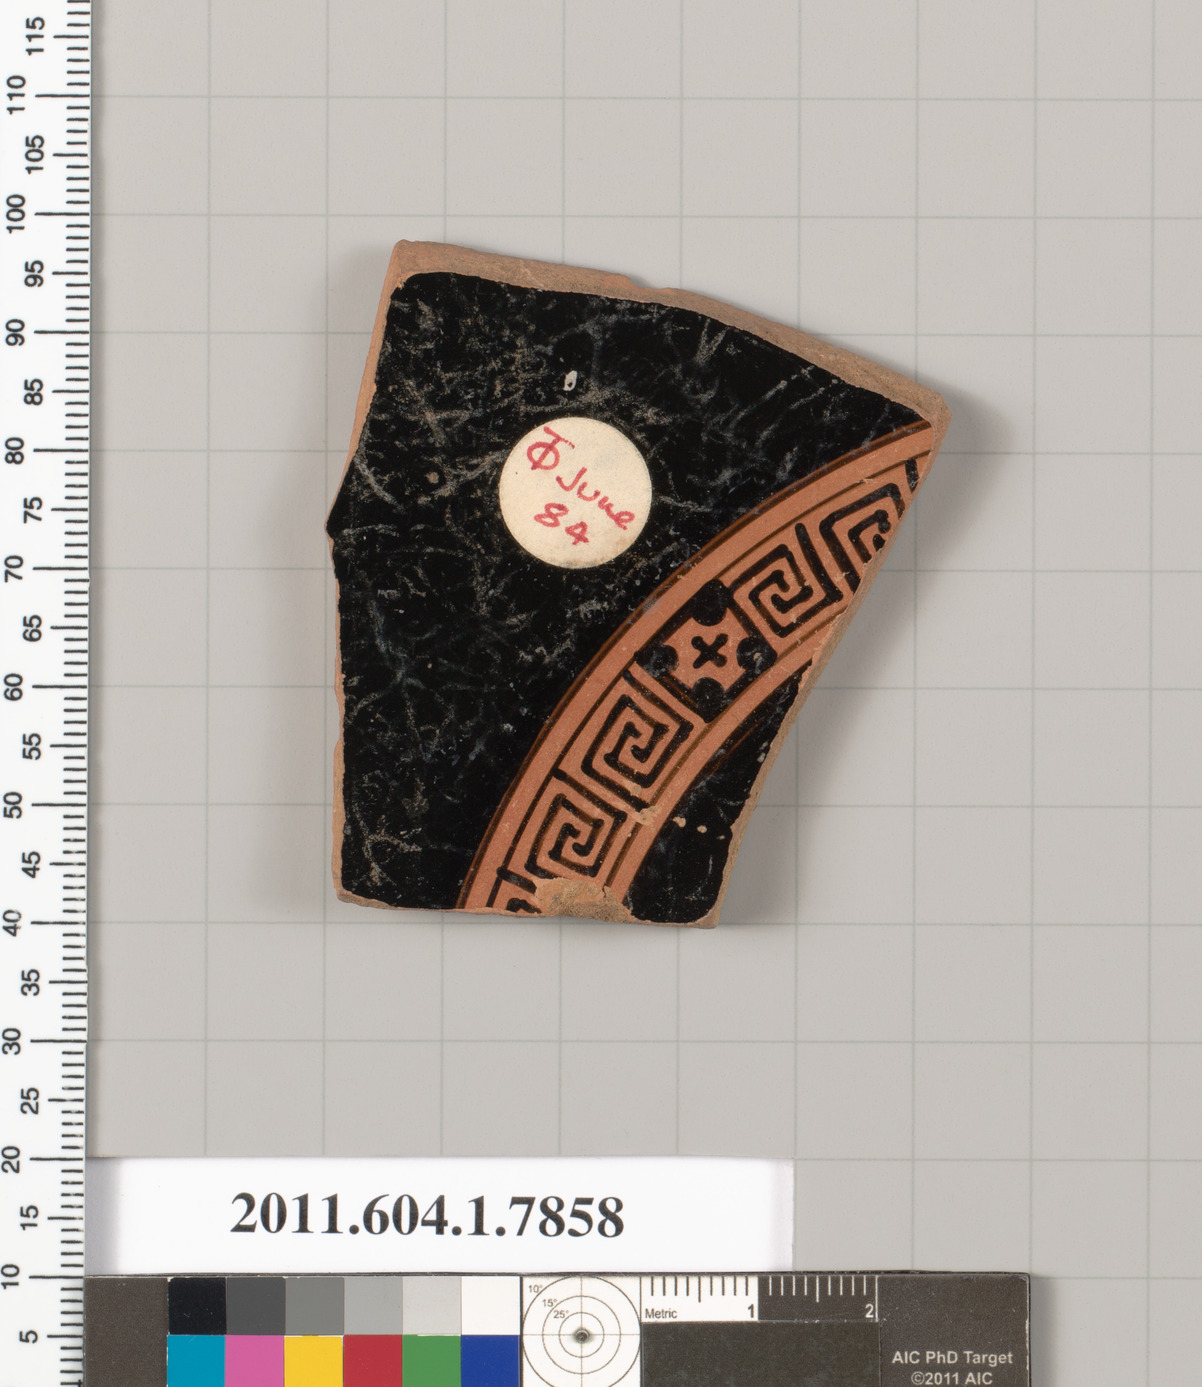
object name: kylix fragment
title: Terracotta fragment of a kylix (drinking cup)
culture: greek, attic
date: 440-420 BCE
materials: terracotta